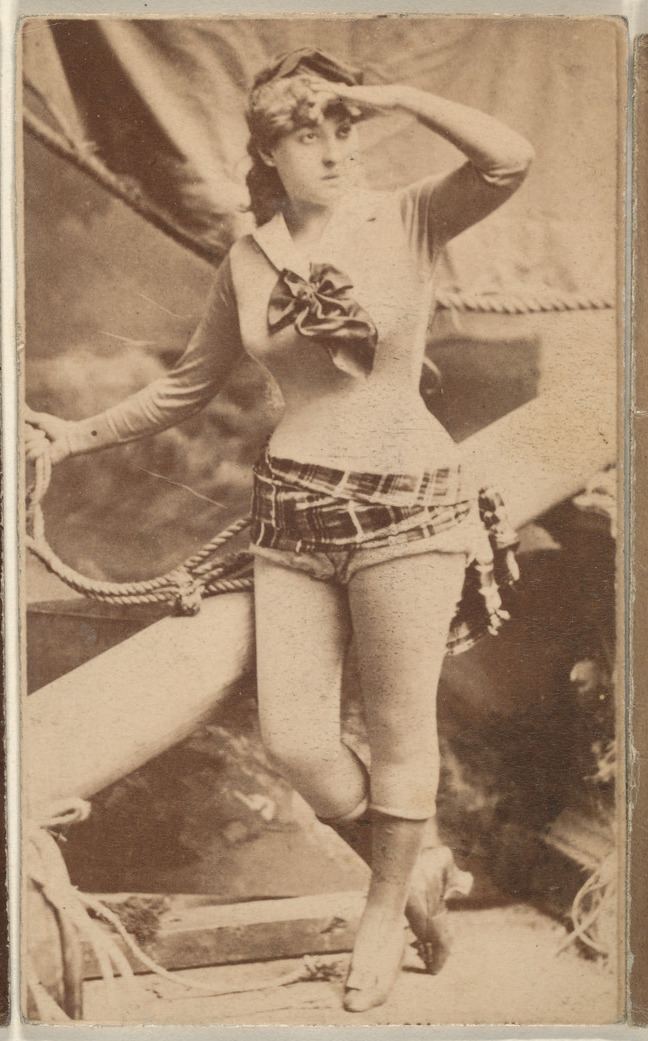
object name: photograph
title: Actress posing with prop ship mast, from the Actresses series (N668)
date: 1888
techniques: albumen silver print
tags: portraits,women,actresses